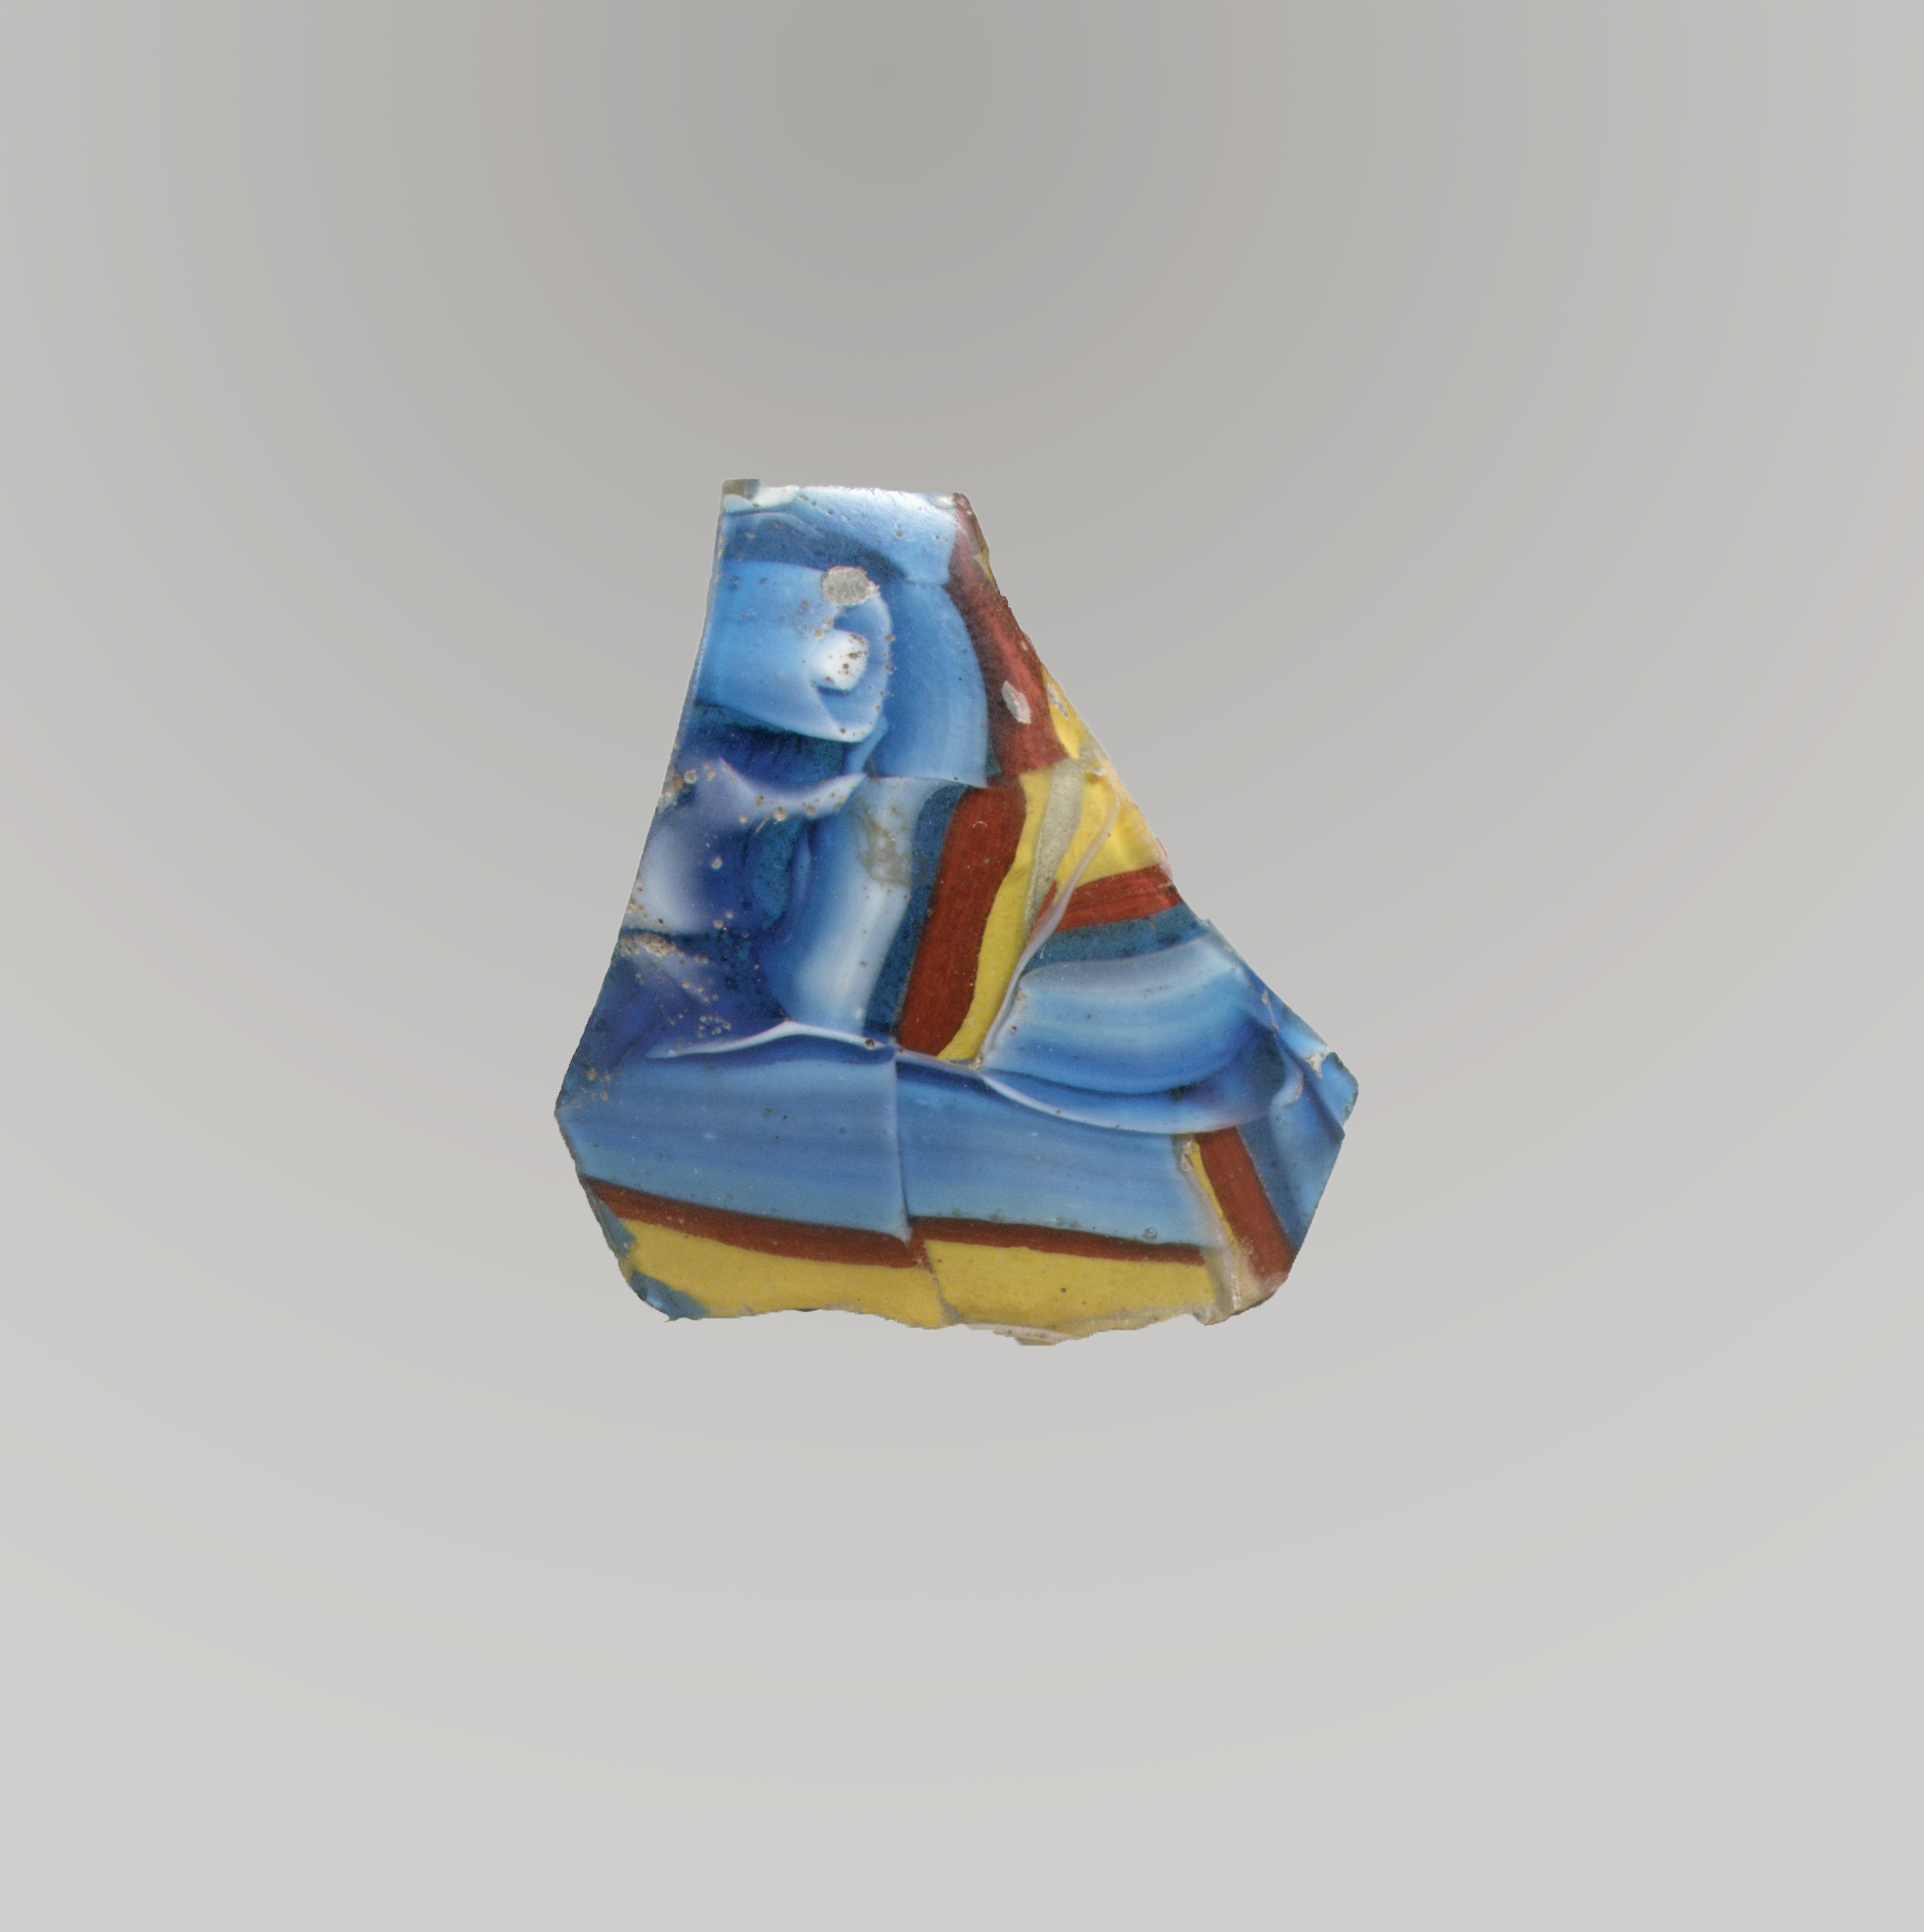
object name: fragment, mosaic bowl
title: Glass mosaic bowl fragment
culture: roman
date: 34 BCE-33 CE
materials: glass